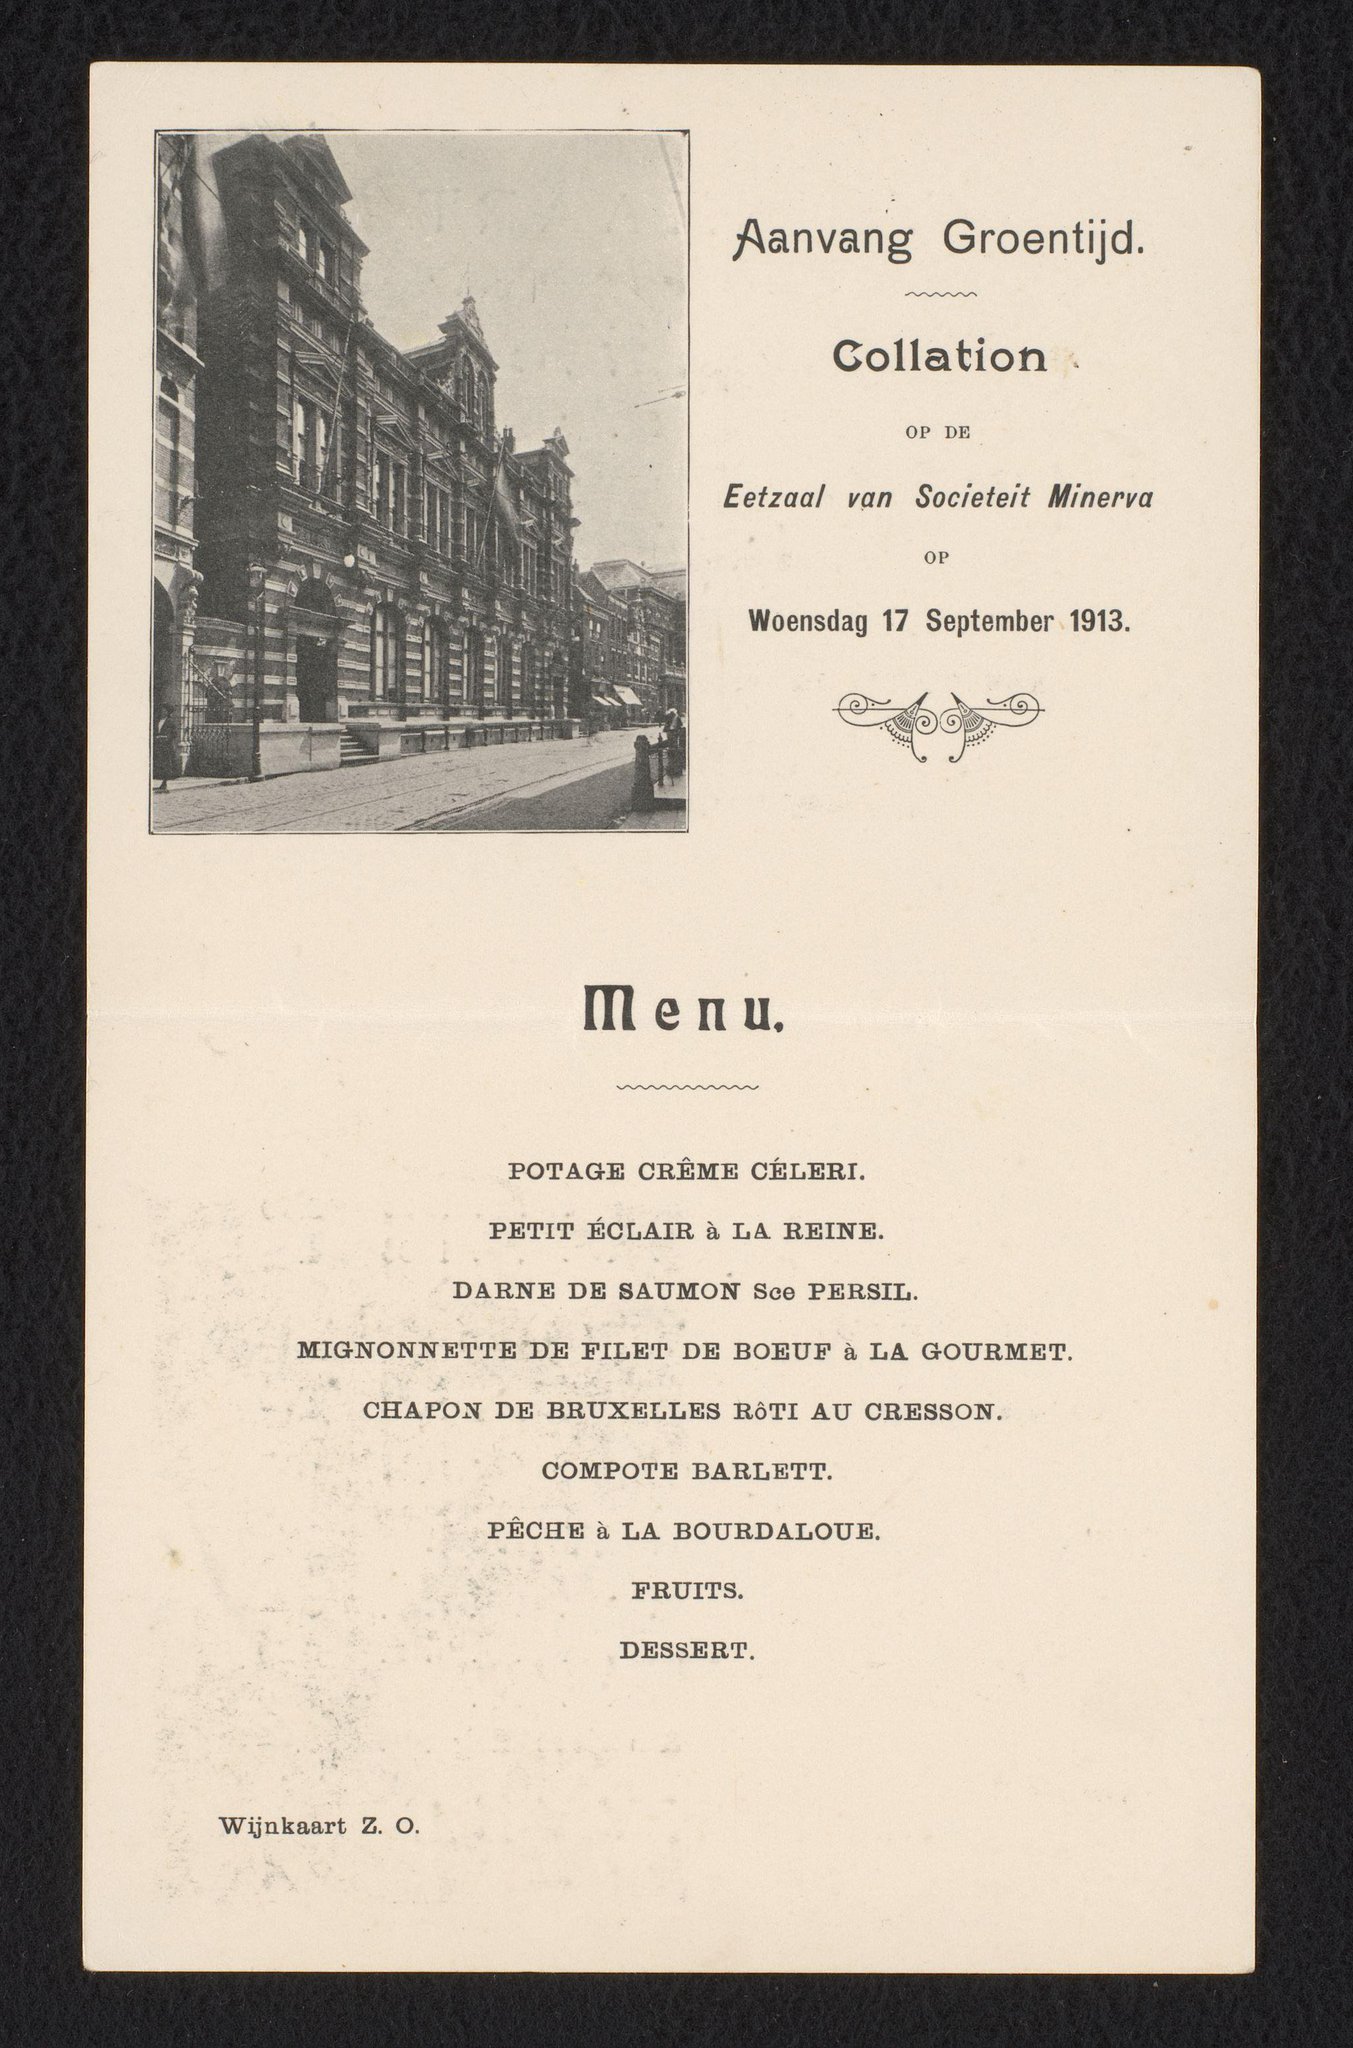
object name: photomechanical print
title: Menukaart voor het diner bij 'Aanvang Groentijd' van sociëteit Minerva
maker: Anonymous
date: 1913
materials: paper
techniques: letterpress printing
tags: the usual house or row of houses, façade (of house or building), leiden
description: Op de voorzijde een gezicht op de gevel van het gebouw van de sociëteit. Daarbij 'Collation op de Eetzaal van Societeit Minerva op Woensdag 17 september 1913' met daaronder het menu. Op de achterzijde de wijnkaart.